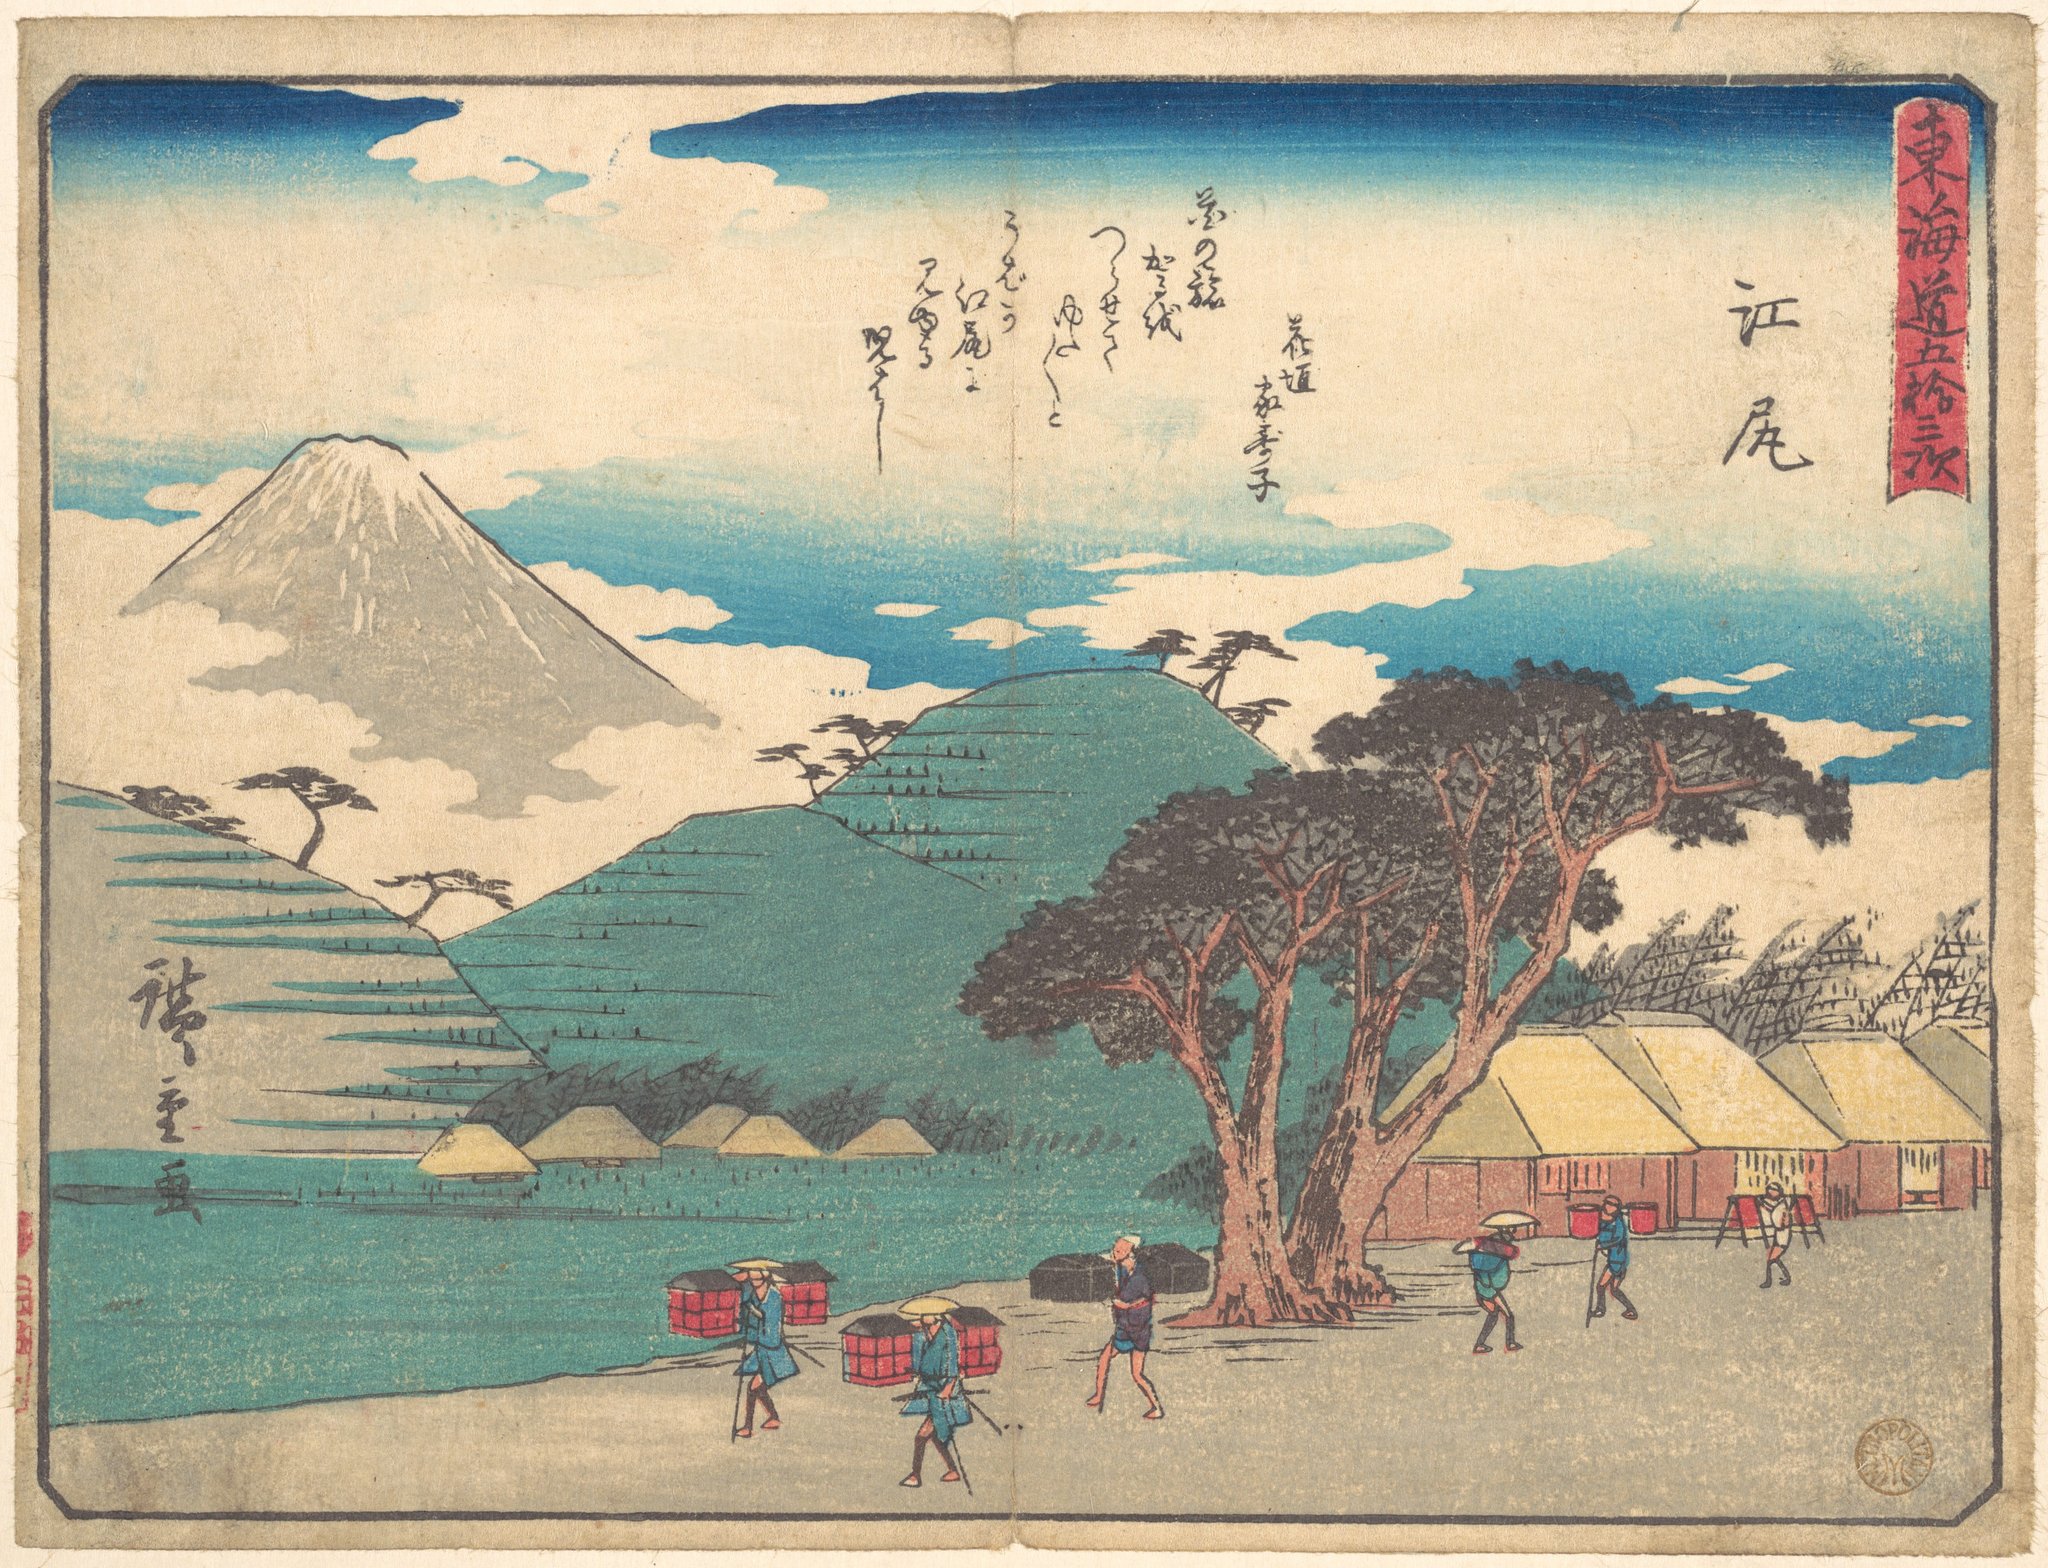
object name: print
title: Ejiri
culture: japanese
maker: utagawa hiroshige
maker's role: artist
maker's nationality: japanese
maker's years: 1797-1858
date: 1838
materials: ink, paper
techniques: woodblock print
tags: human figures,houses,mountains,landscapes,trees